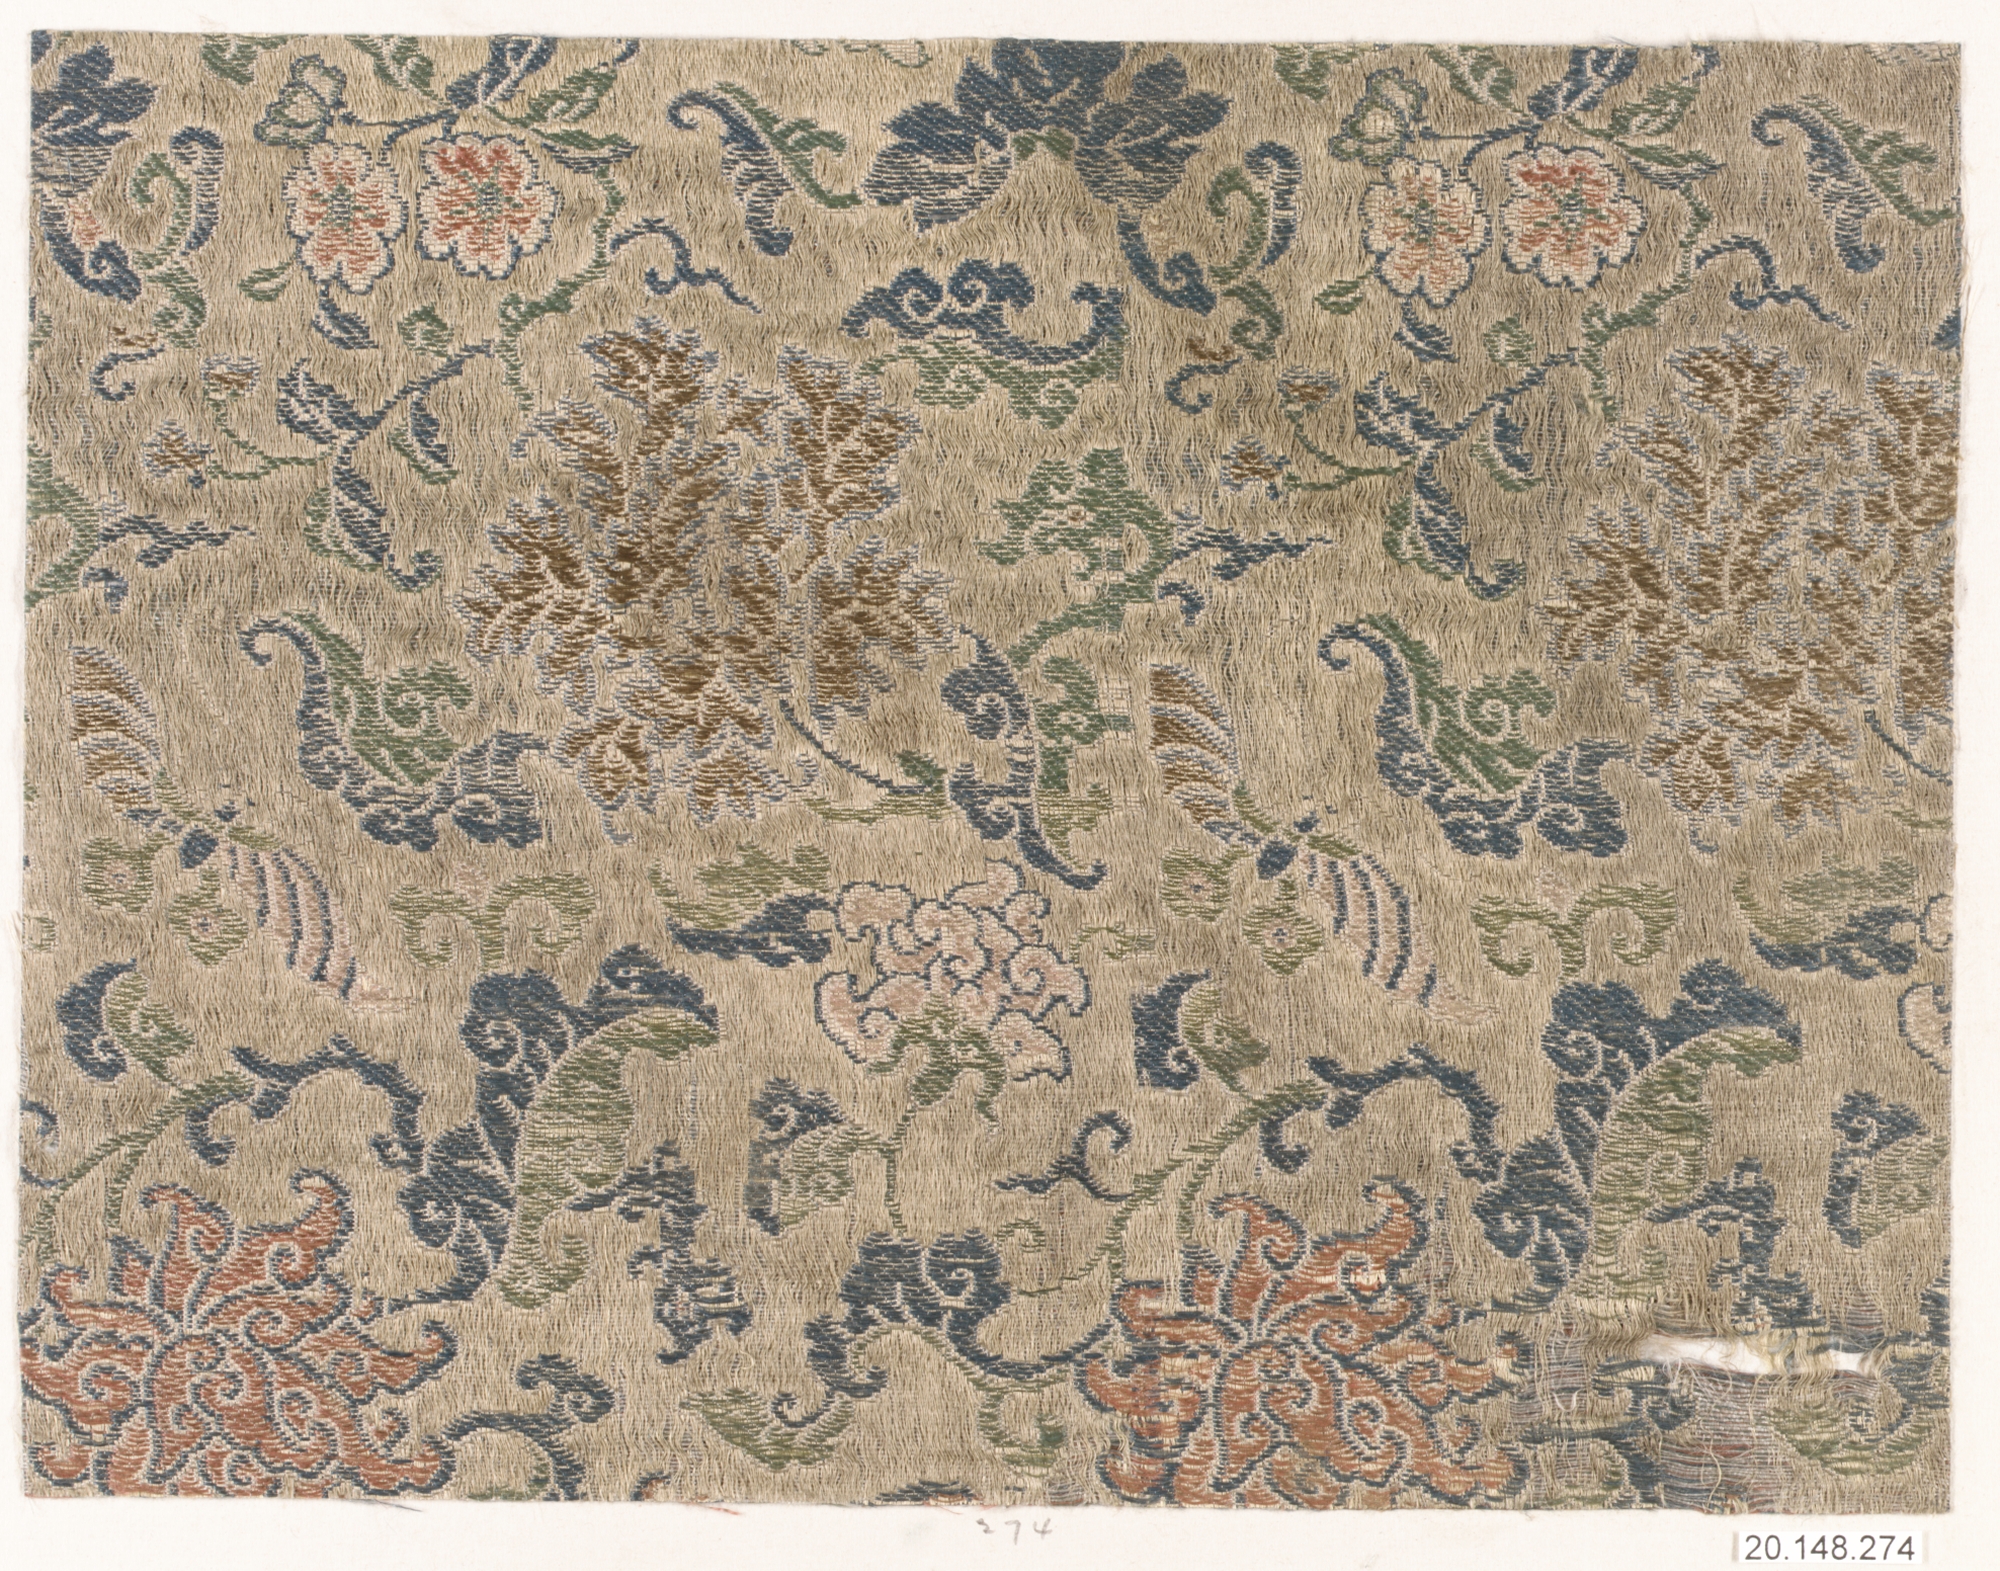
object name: piece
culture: japanese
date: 1701-1800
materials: silk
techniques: compound weave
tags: flowers,leaves